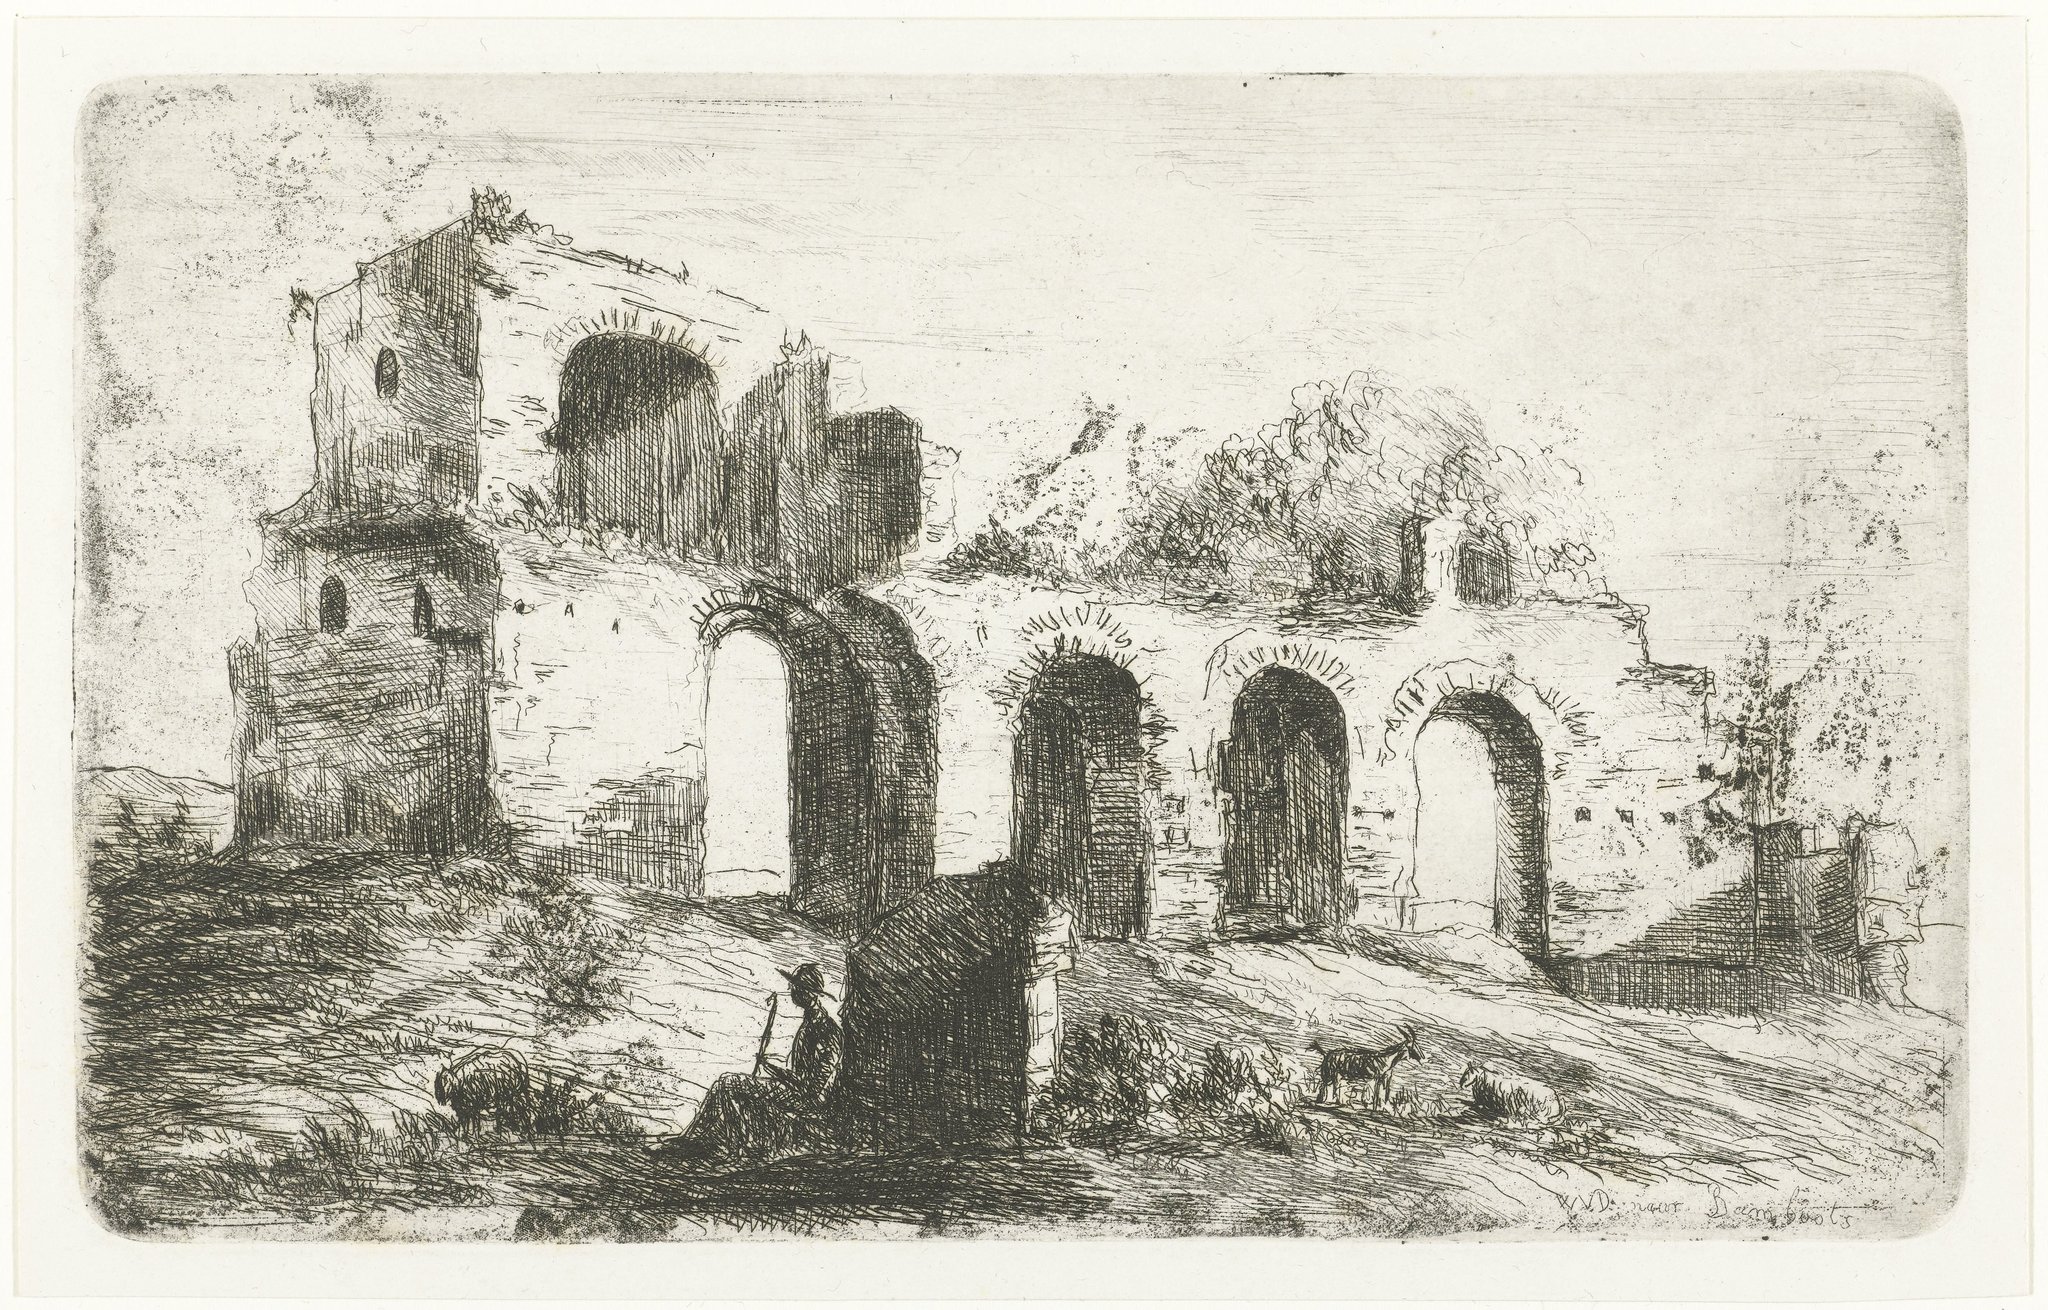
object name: print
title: Zuidelijk landschap met ruïne en herder met vee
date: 1815-1867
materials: paper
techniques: etching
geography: netherlands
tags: herding, herdsman, herdswoman, shepherd, shepherdess, cowherd, etc., landscape with ruins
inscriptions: collector's mark: Lugt 2228